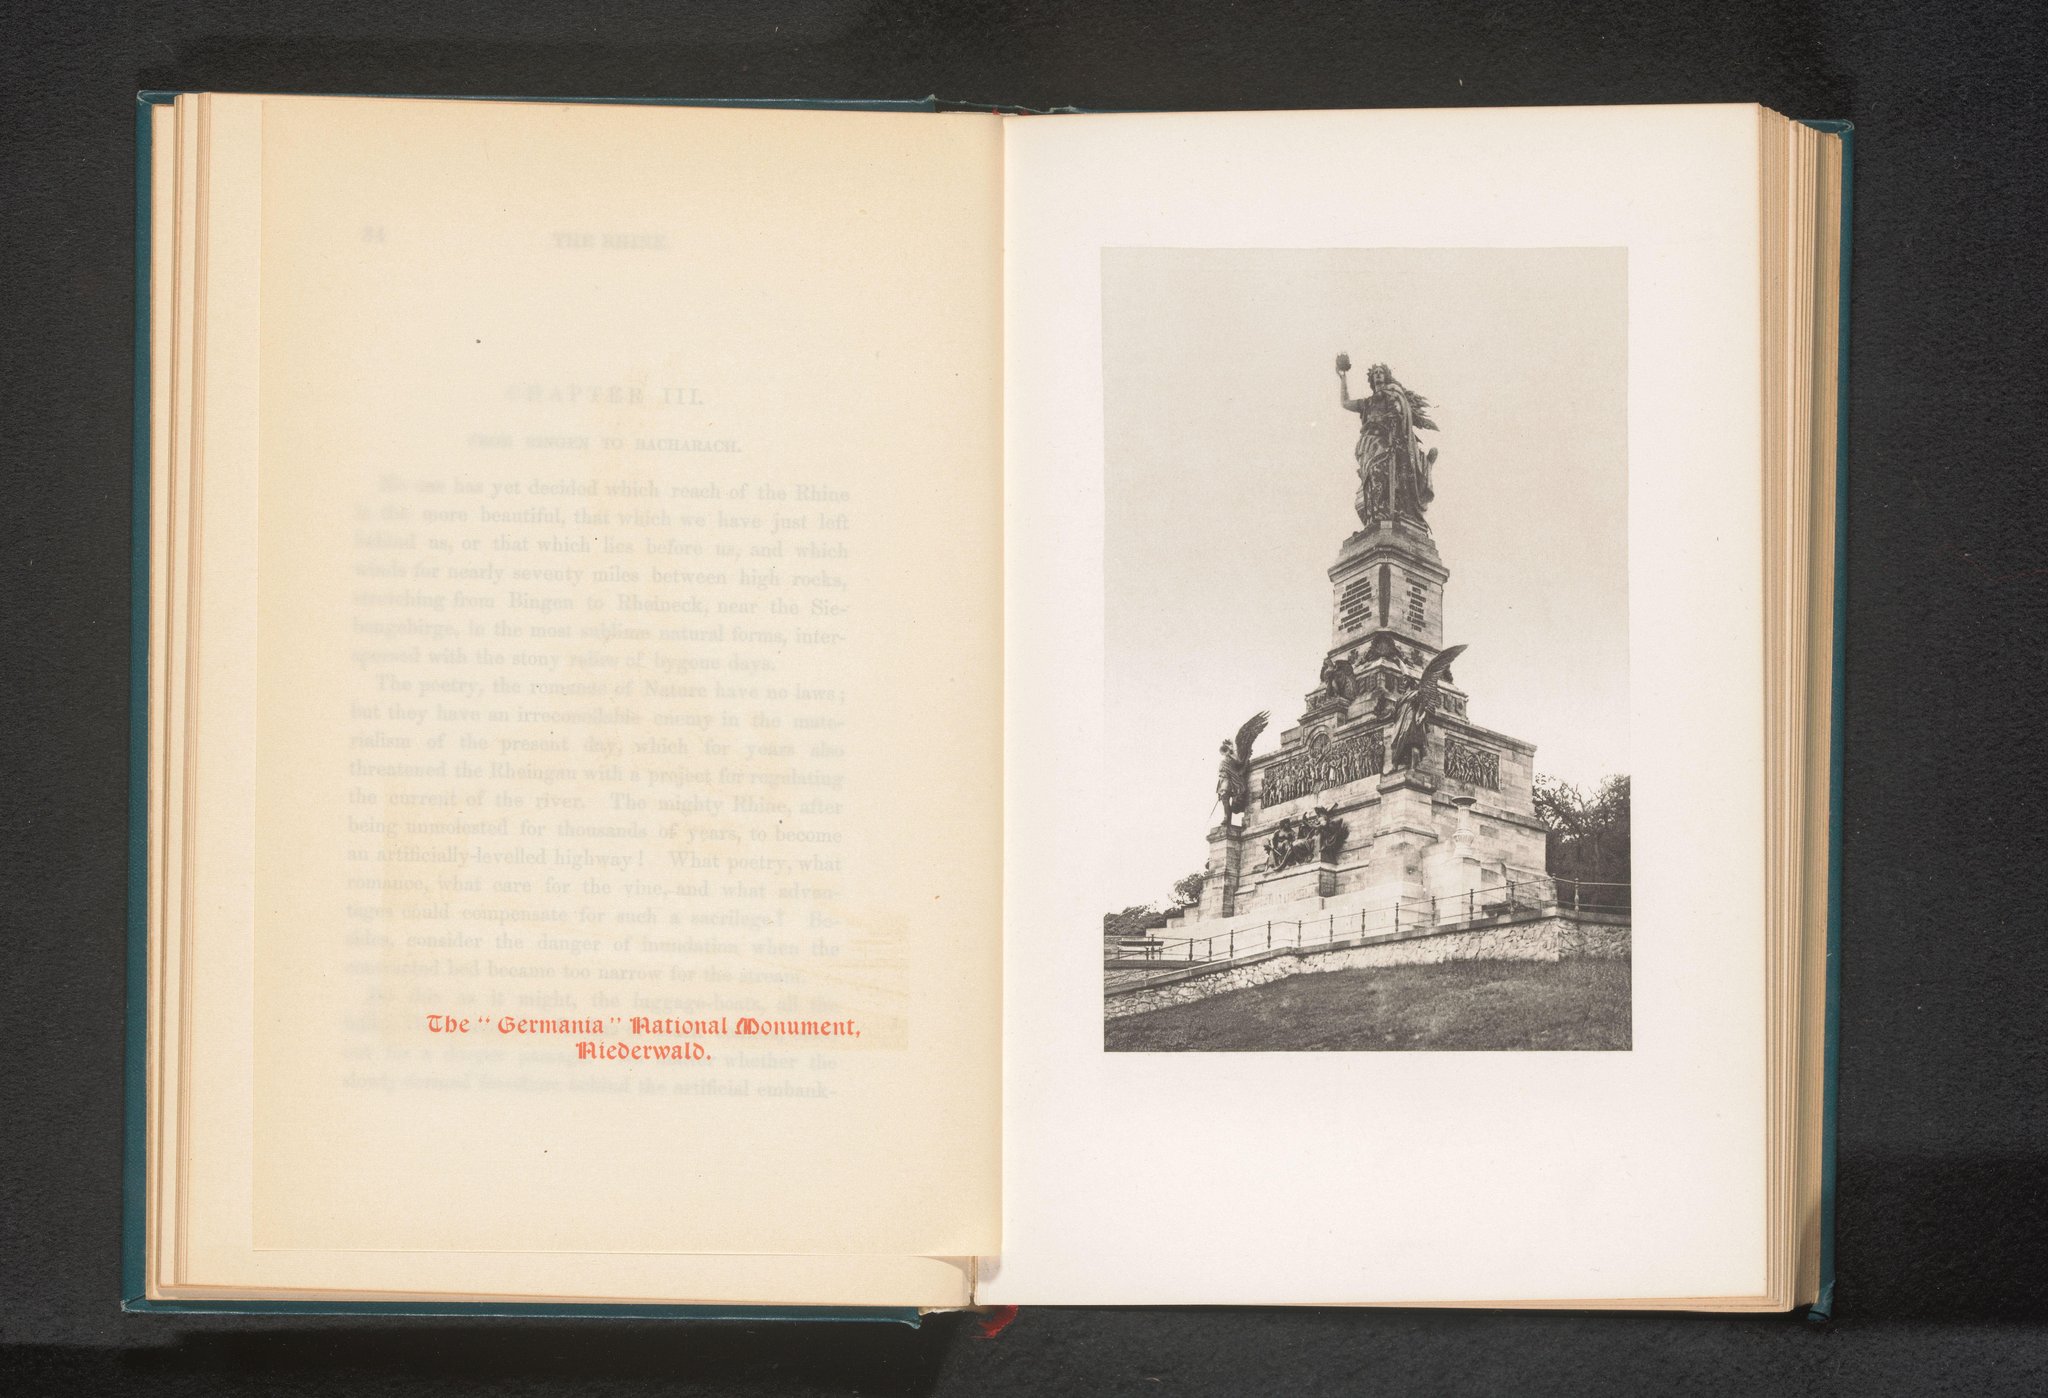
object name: page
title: Niederwalddenkmal nabij Rüdesheim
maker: Anonymous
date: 1889-1899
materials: paper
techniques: photoaquatint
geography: hessen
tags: landscape with monument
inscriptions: title: ‘The "Germania" National Monument, Niederwald.’